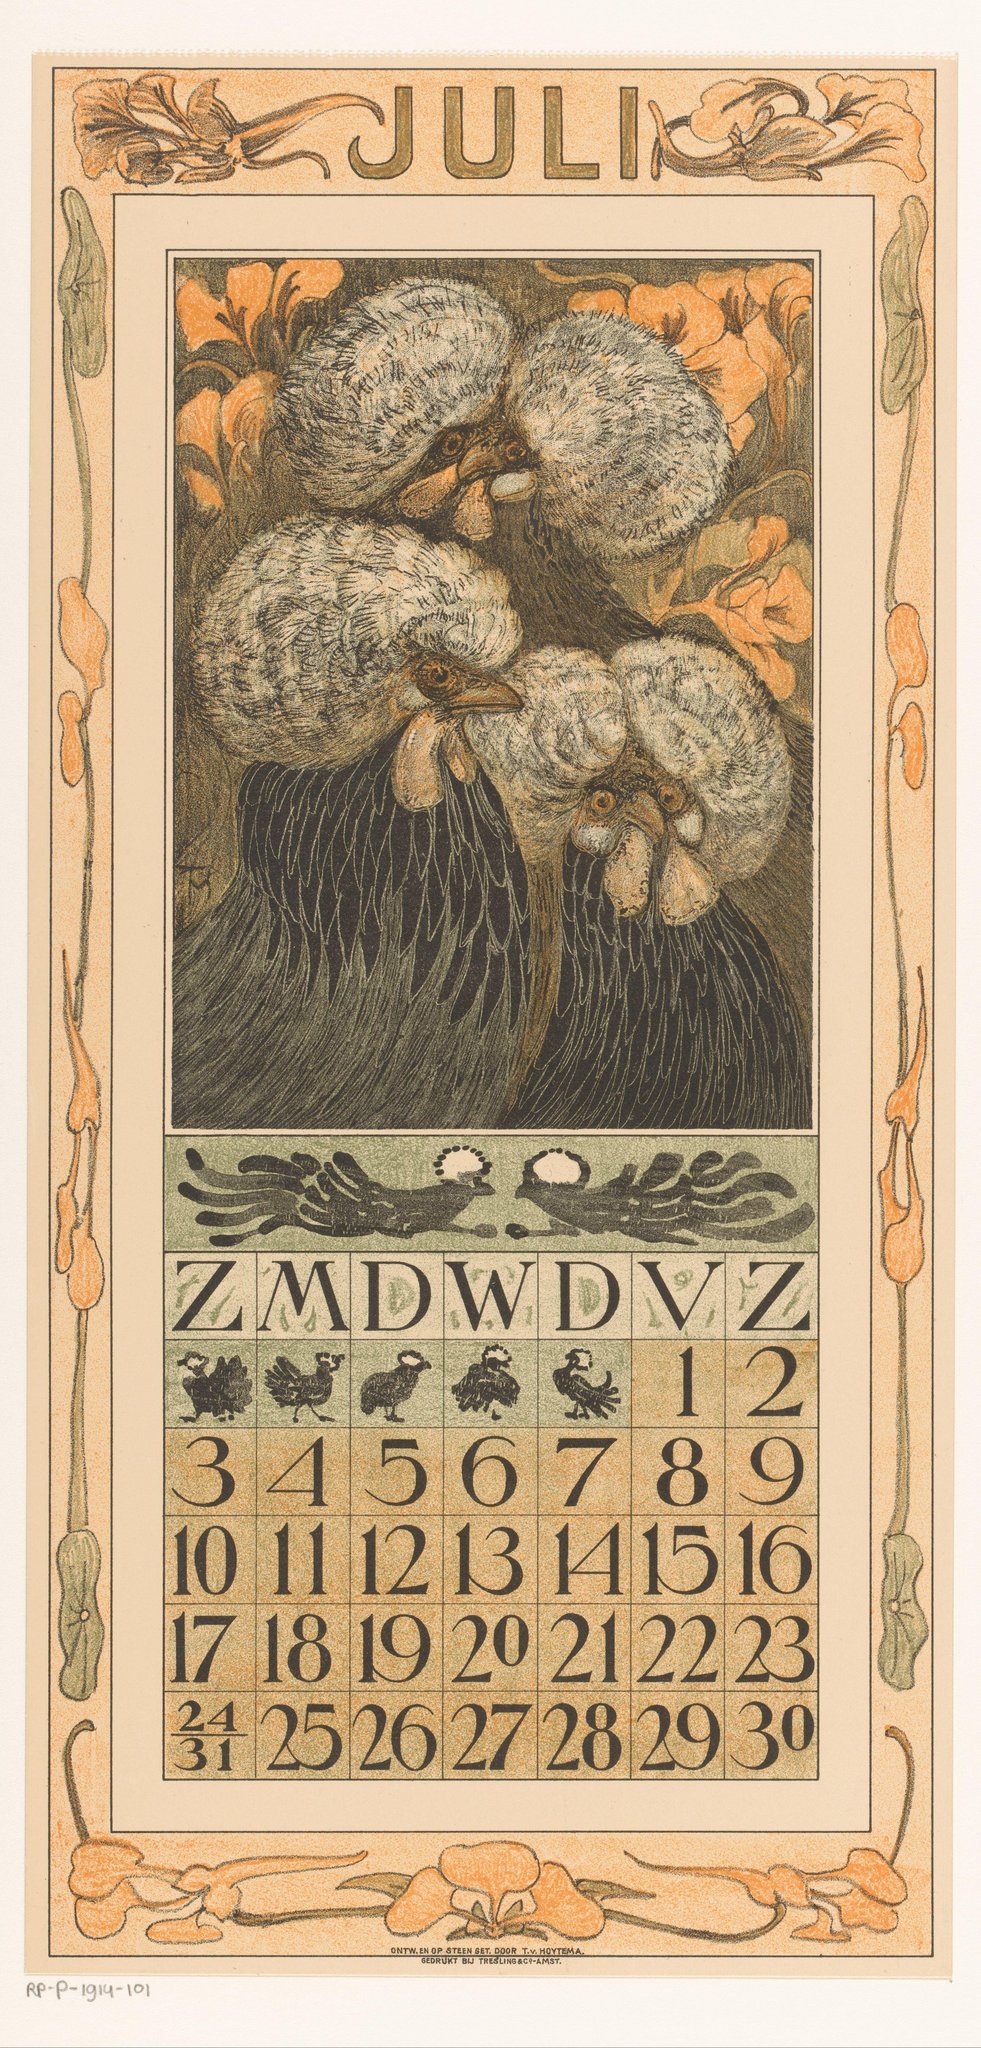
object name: print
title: Kalender 1910 12 lithografien door Th. v. Hoytema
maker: theo van hoytema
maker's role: draughtsman, painter, print maker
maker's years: 1863-1917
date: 1909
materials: paper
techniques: lithograph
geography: amsterdam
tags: fowl (cock, hen, chicken, etc.), july ~ other concepts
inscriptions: collector's mark: Lugt 2228